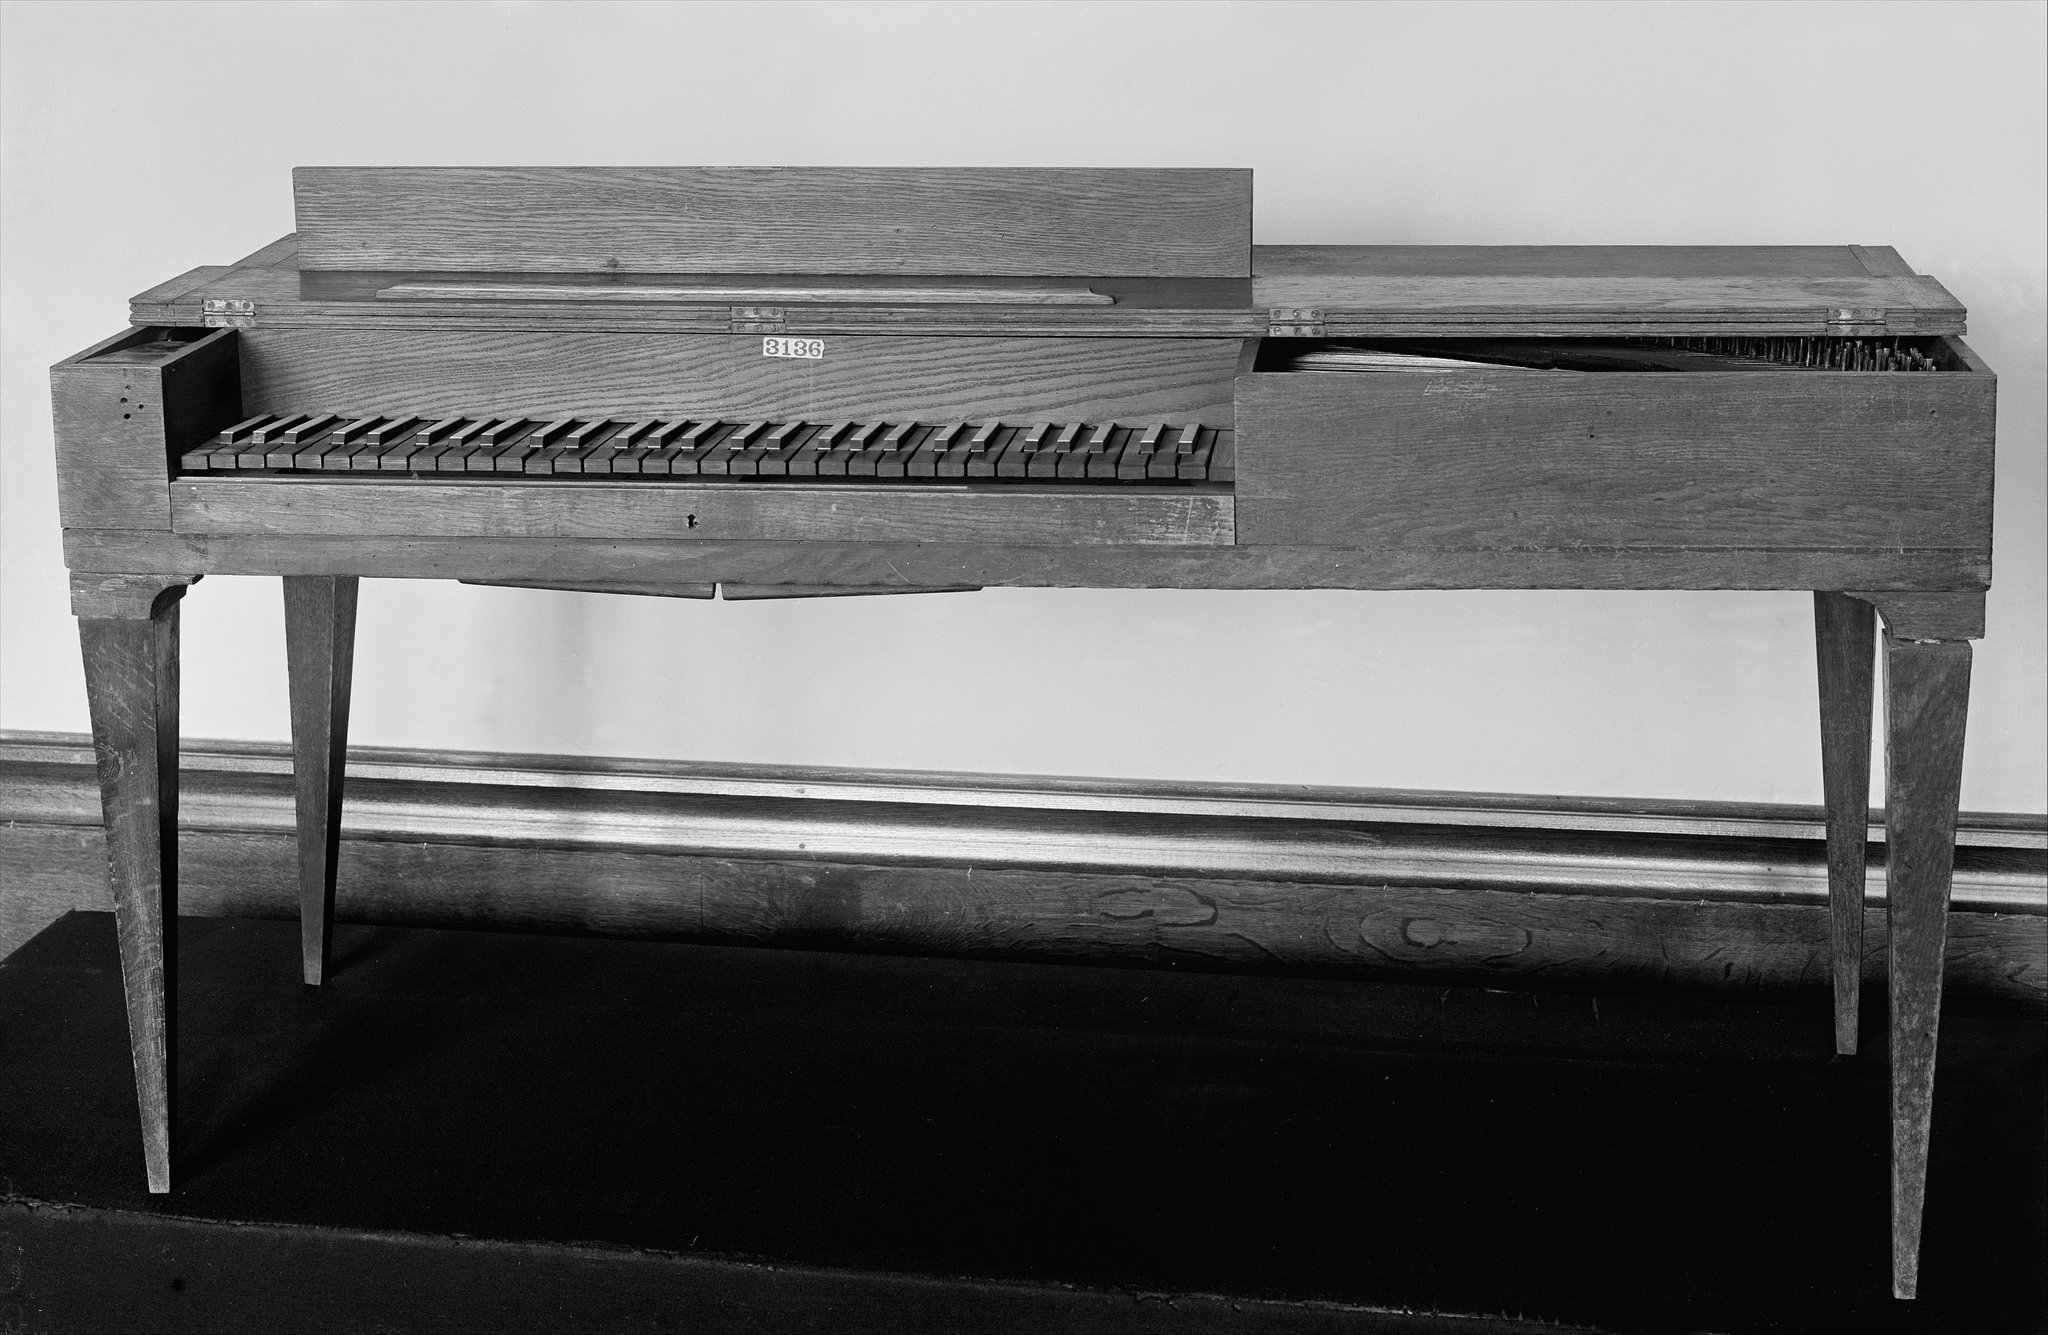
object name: square piano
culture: german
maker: ignace-joseph senft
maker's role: maker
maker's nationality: german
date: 1767-1800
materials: bone, wood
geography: germany